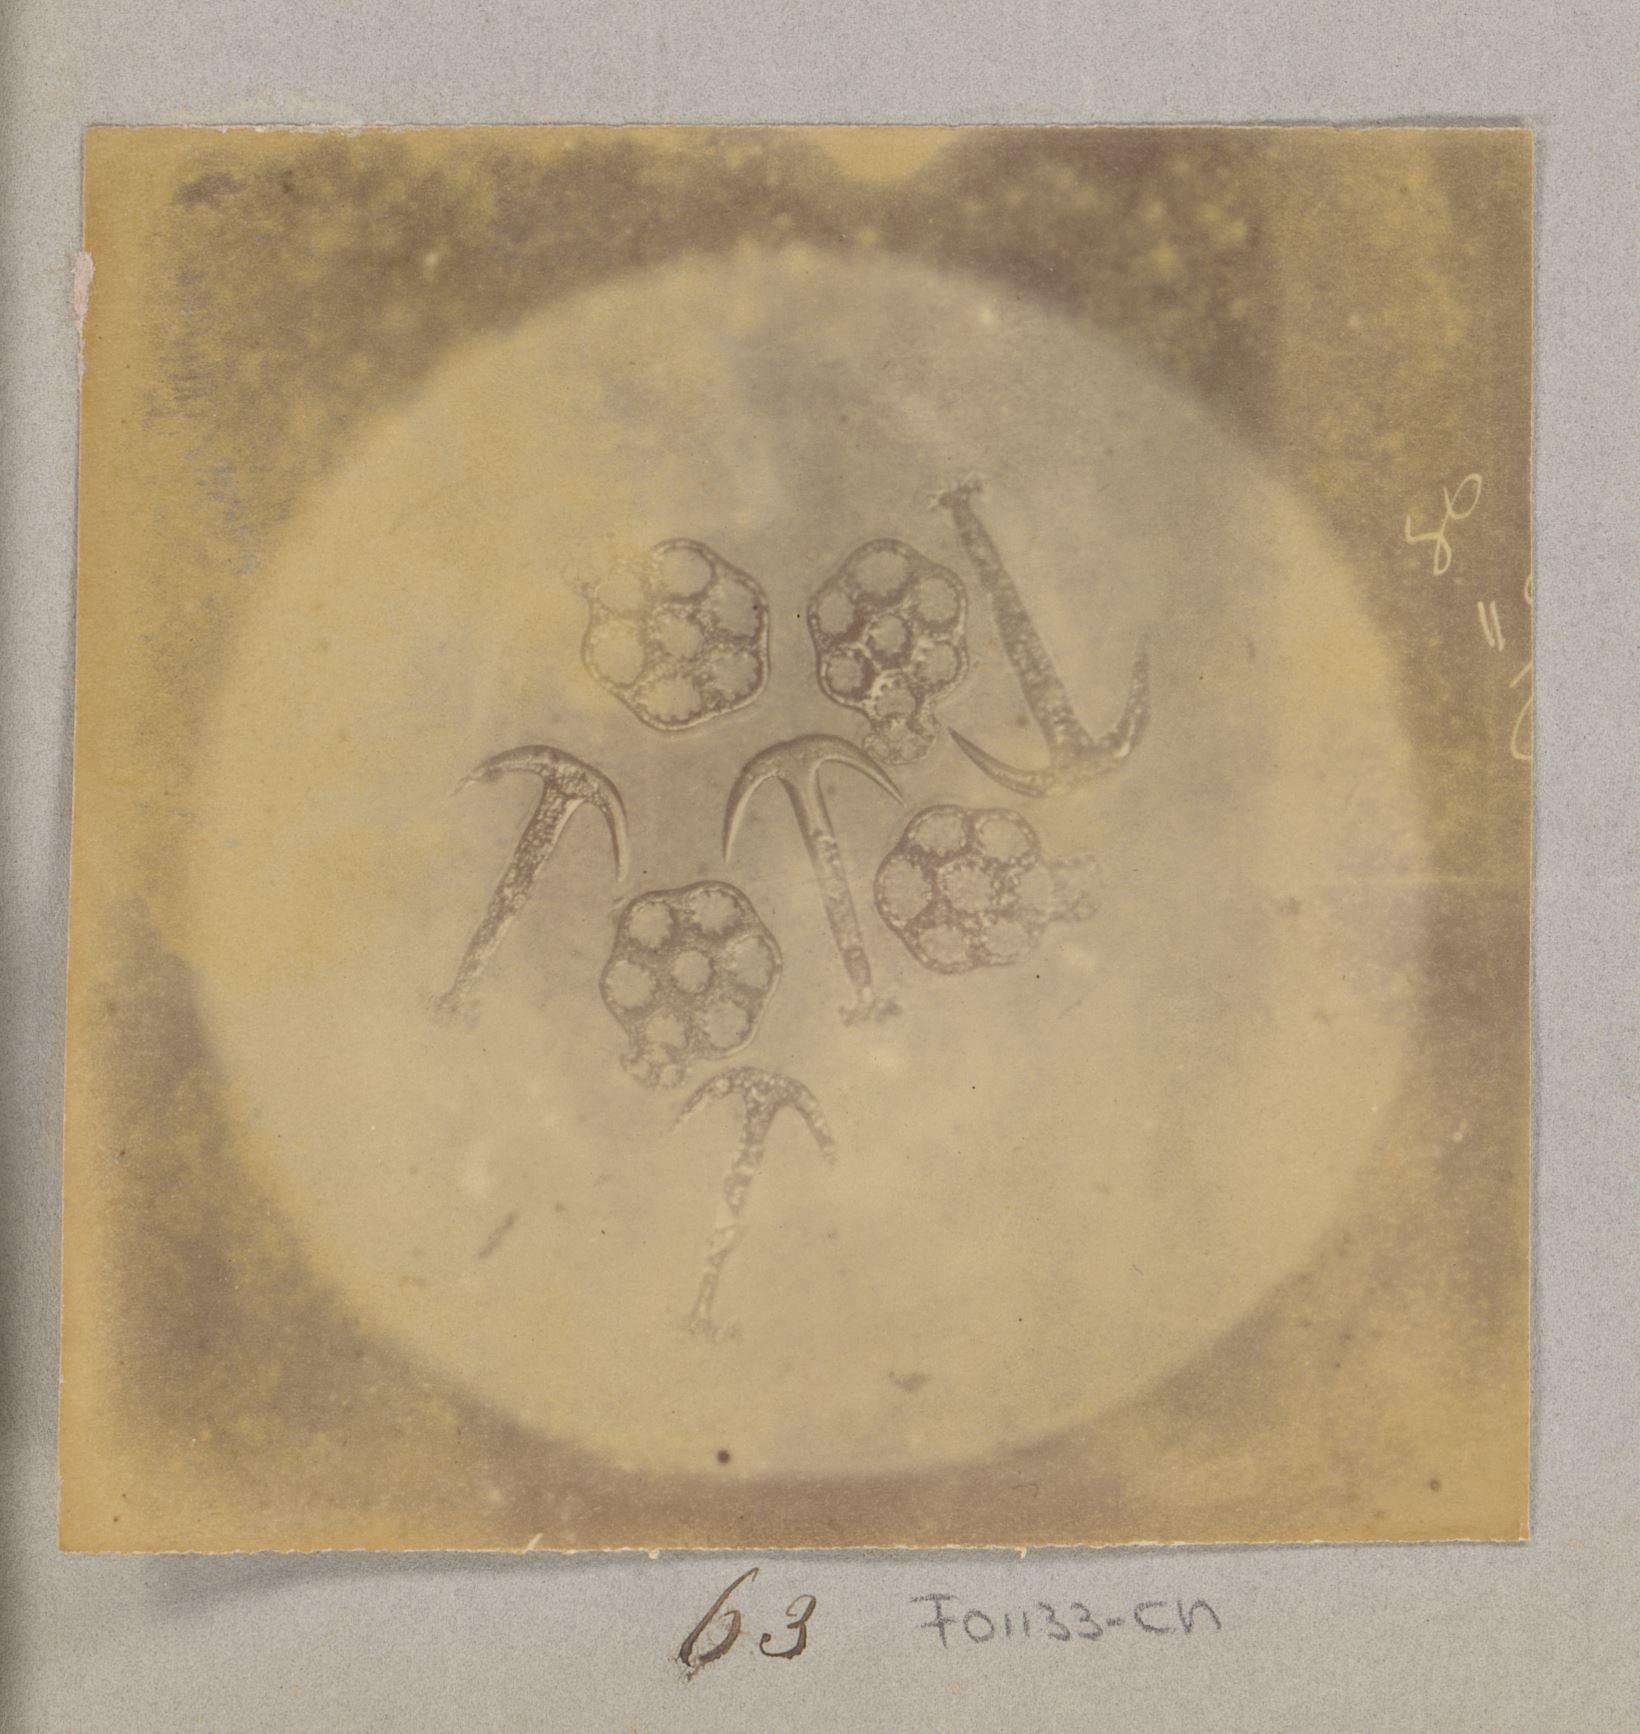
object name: photograph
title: Microscopische opname van synapta glabra-diatomeeën, zestig keer vergroot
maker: marinus pieter filbri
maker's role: instrument maker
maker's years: 1852-1917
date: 1887-1888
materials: paper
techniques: albumen print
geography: netherlands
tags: algae, seaweed, netherlands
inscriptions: inscription: ‘No. 63. Benaming Diatomeen Synapta Glabra, vergroting 60 x, pose 12 m., Bemerking idem’, number: ‘63’